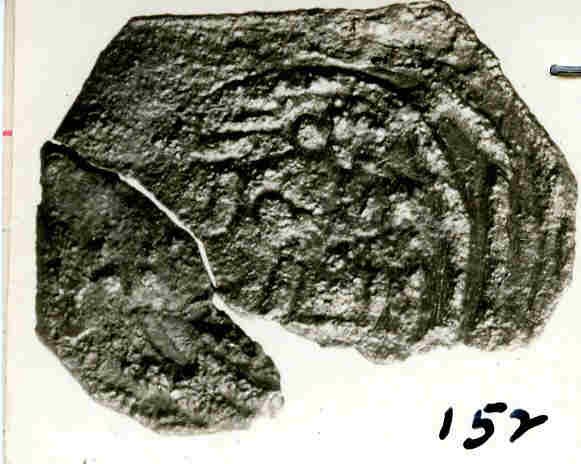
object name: coin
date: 701-900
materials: copper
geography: iran